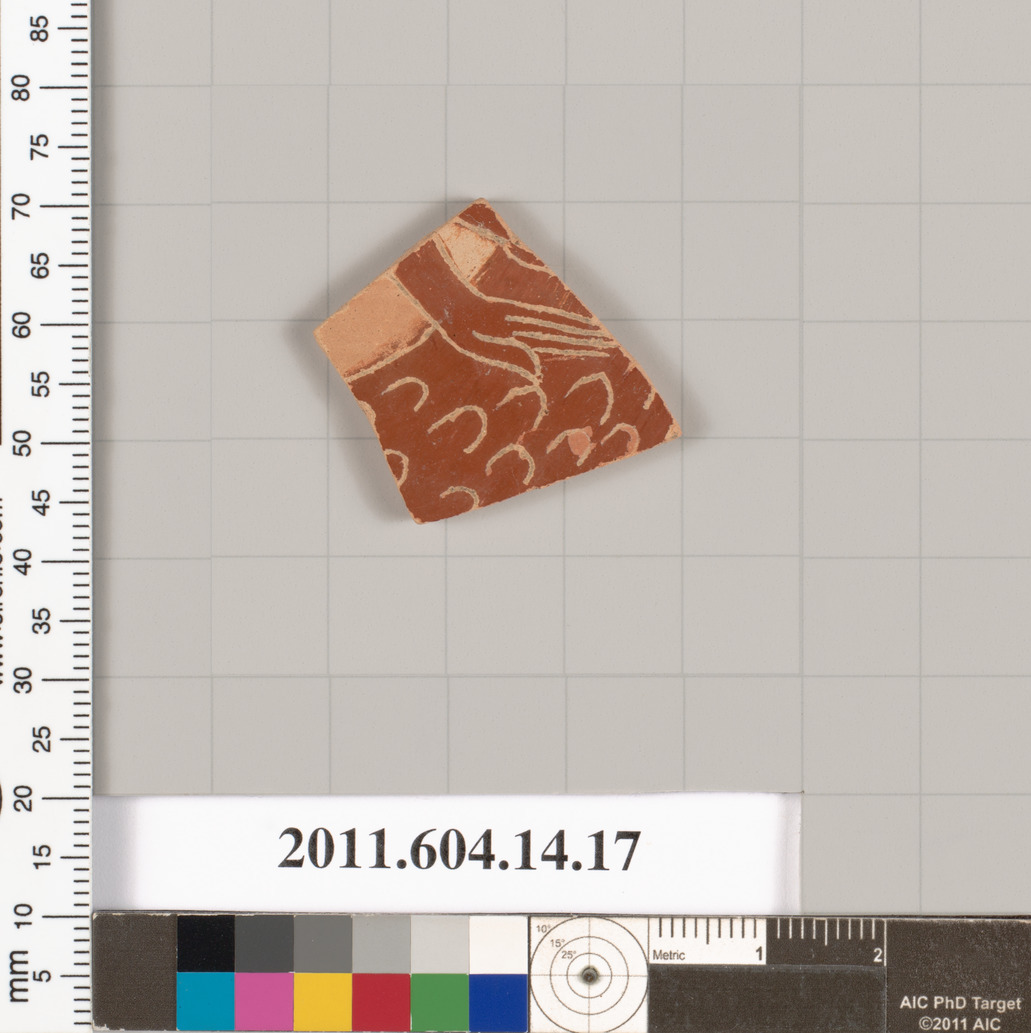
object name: undetermined closed shape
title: Terracotta fragment of an undetermined closed shape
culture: unknown fabric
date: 600-501 BCE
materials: terracotta